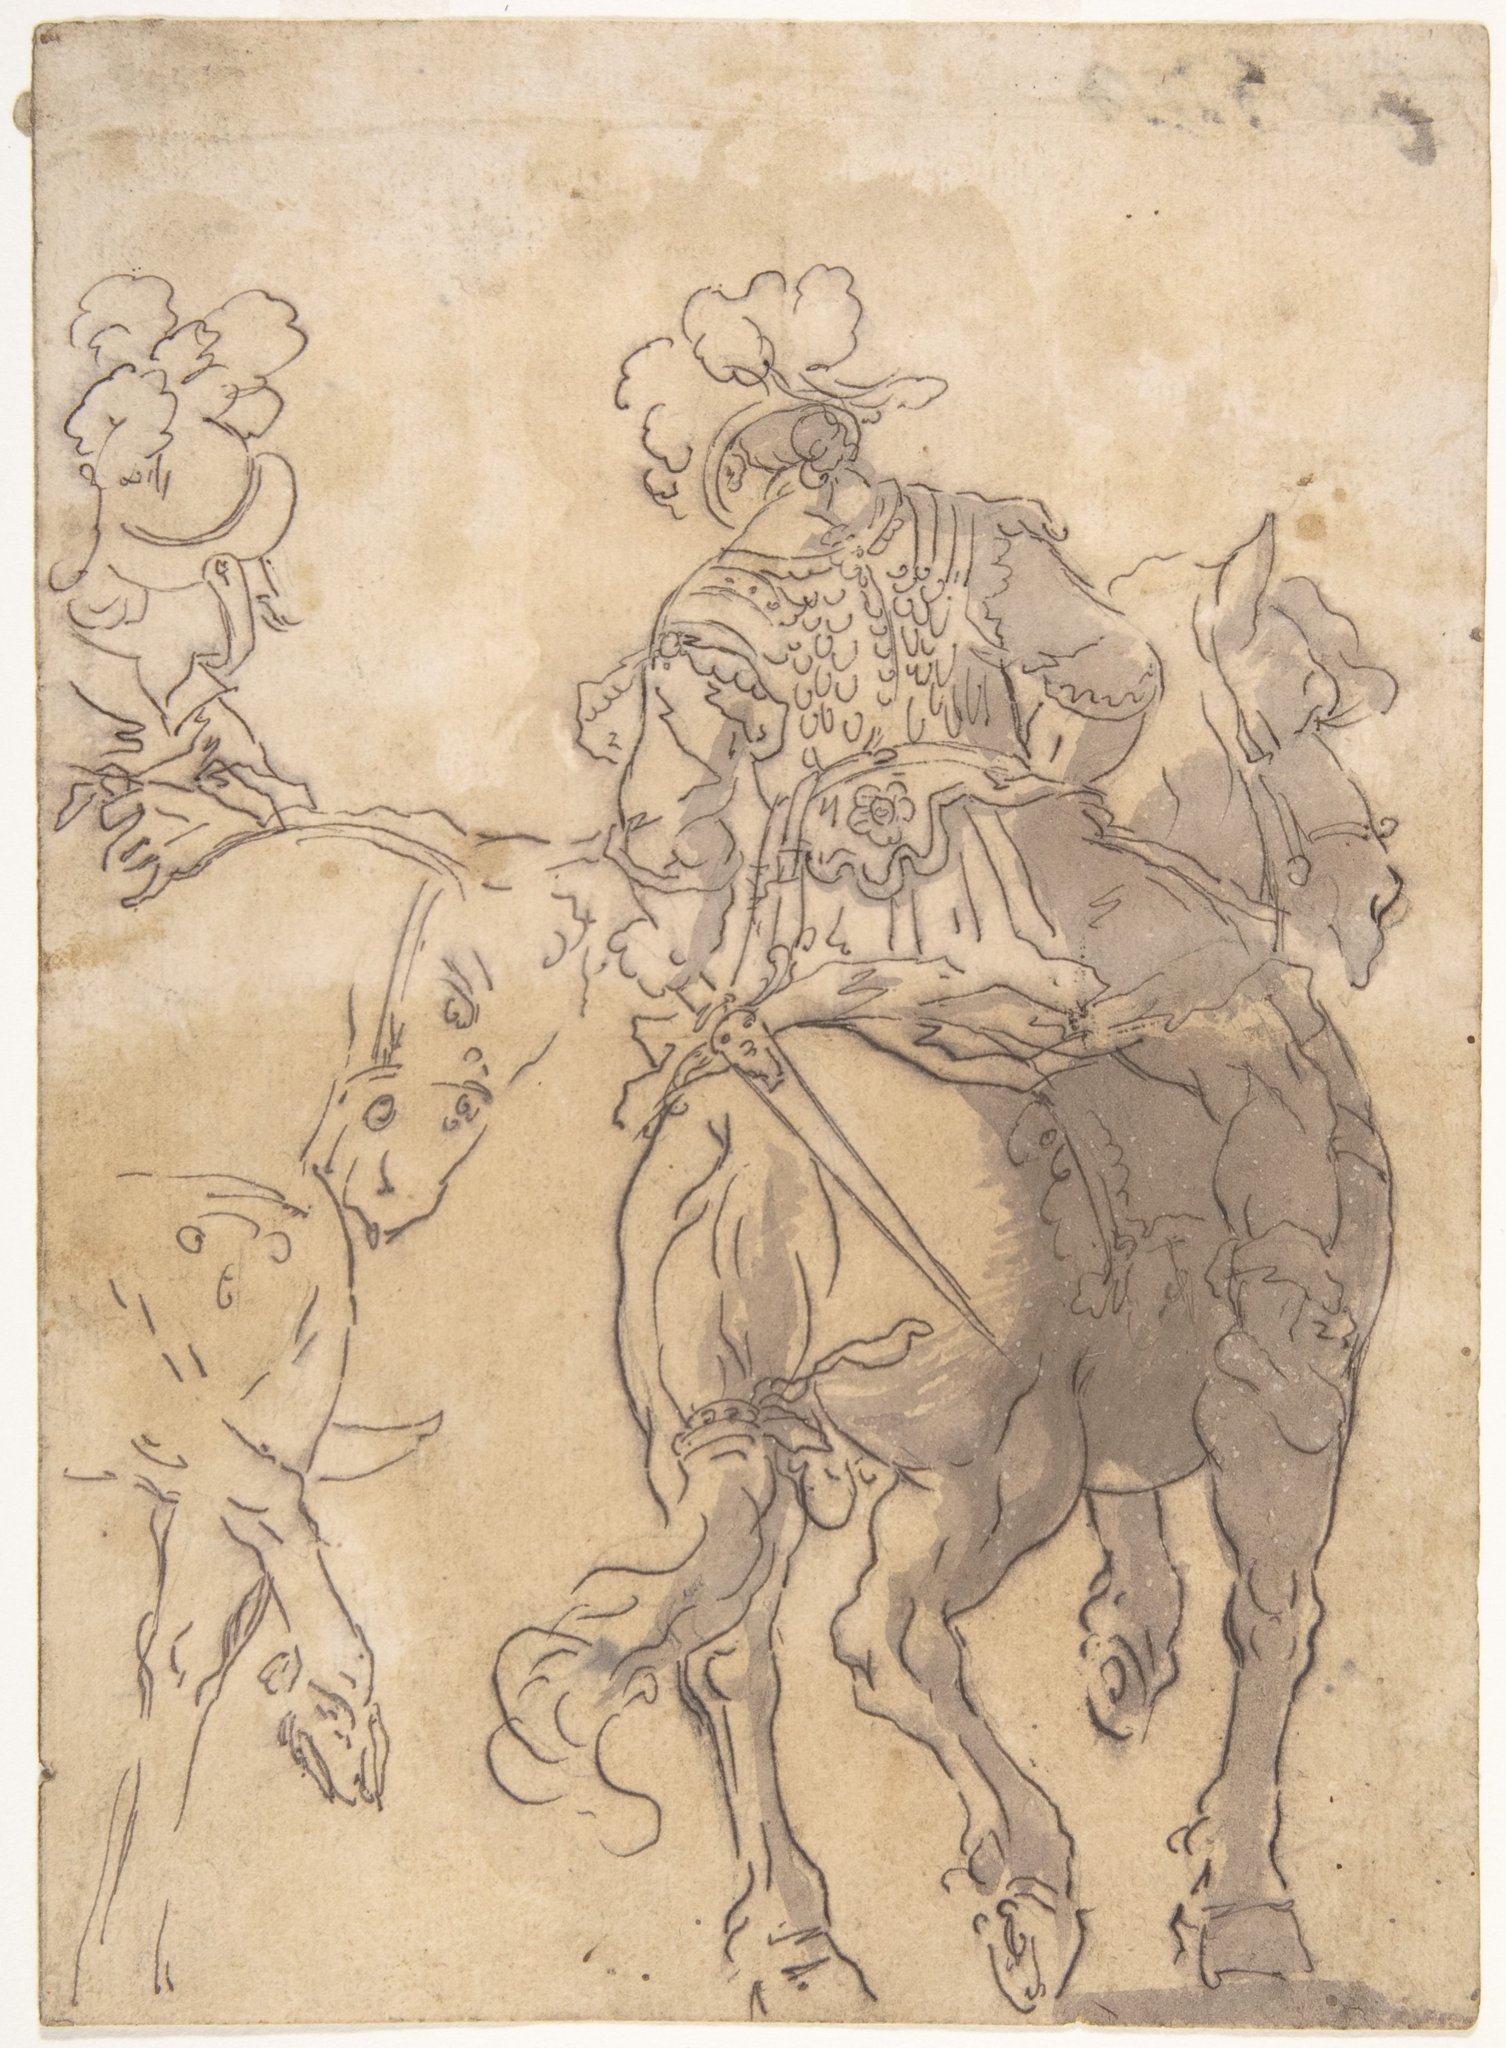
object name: drawing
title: Two Horsemen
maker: anonymous, italian, 17th century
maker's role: artist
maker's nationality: italian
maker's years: 1600-1700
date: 1601-1700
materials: ink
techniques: pen, wash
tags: men,horses